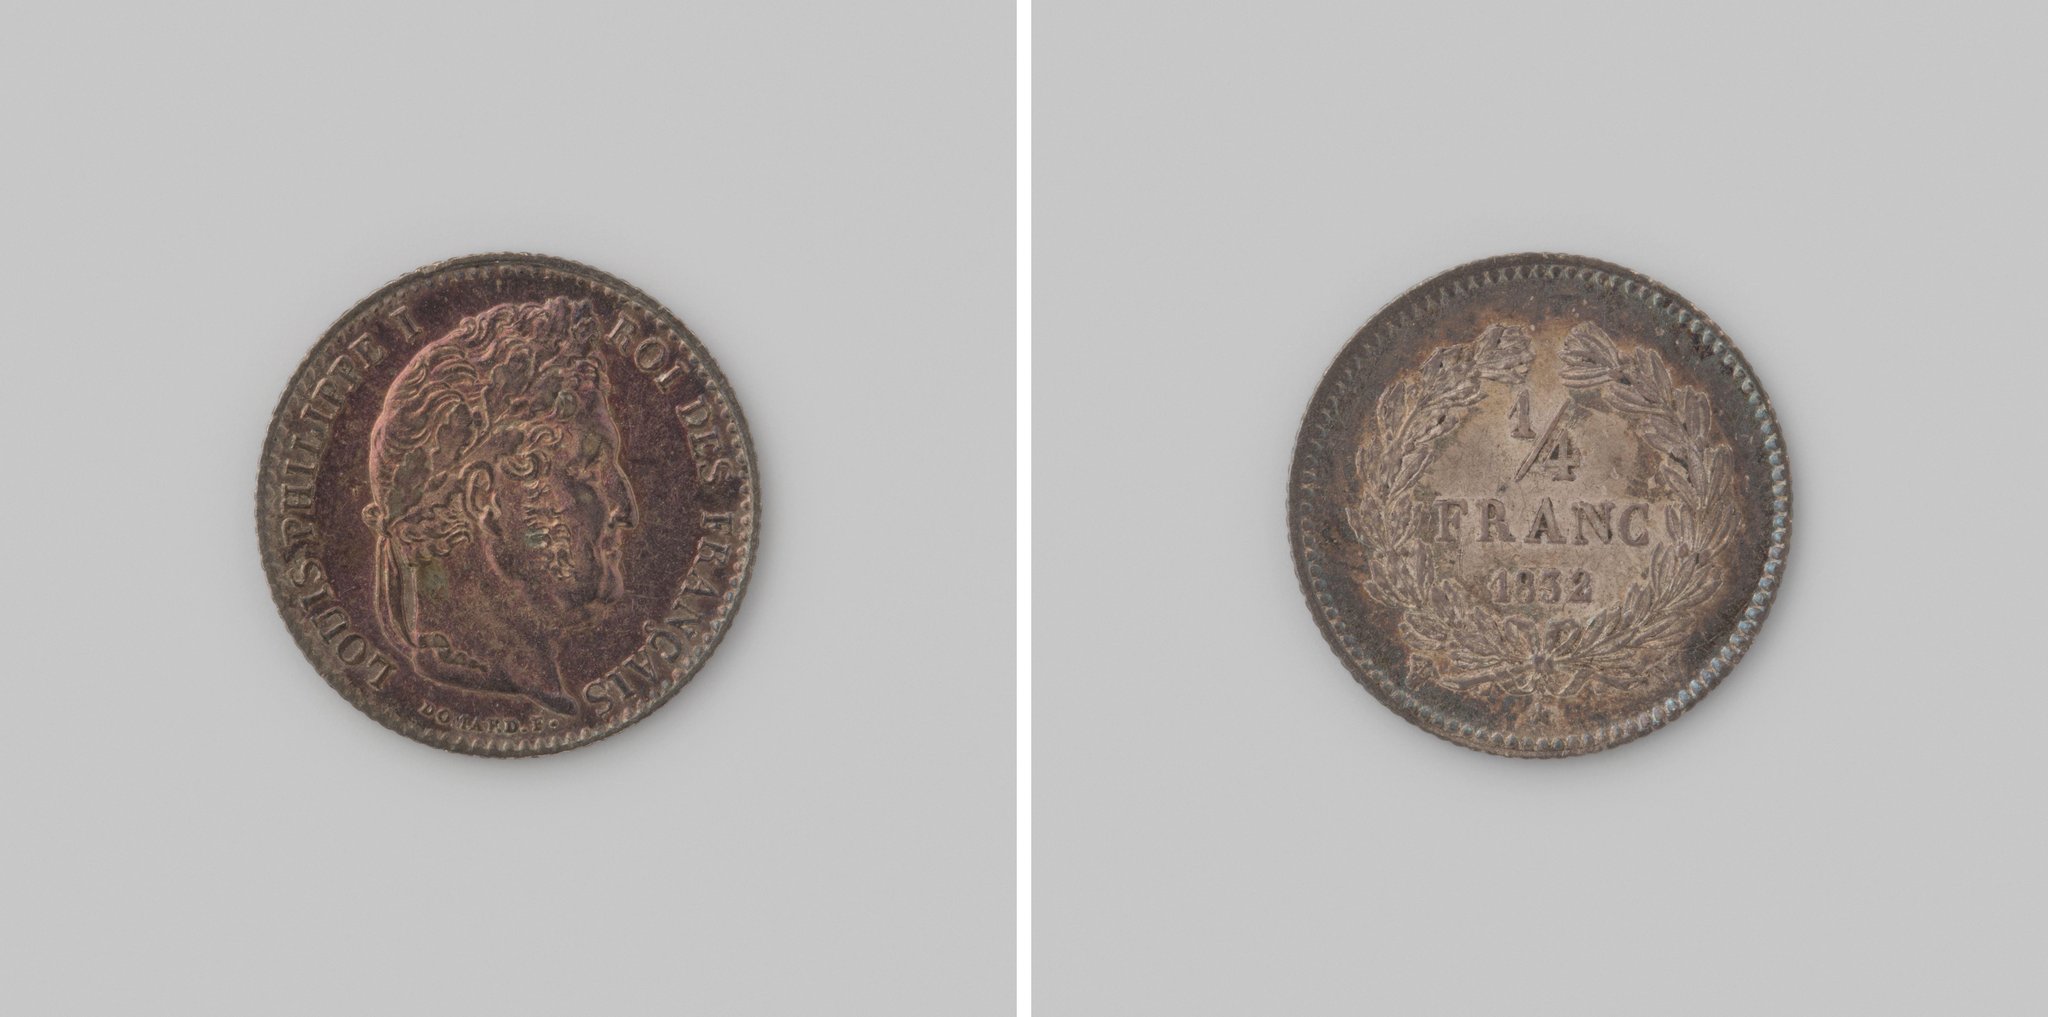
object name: coin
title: Koninkrijk Frankrijk, Louis Philippe I, 1/4 franc, 1832 A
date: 1832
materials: silver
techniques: striking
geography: lille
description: Zilveren munt. Voorzijde: hoofd van de koning met krans van eikenbladeren naar rechts. Keerzijde: binnen twee samengebonden lauriertakken waarde-aanduiding in twee regels, waaronder jaartal. Onderaan rechts letter VV [=Lille]. Kartelrand.